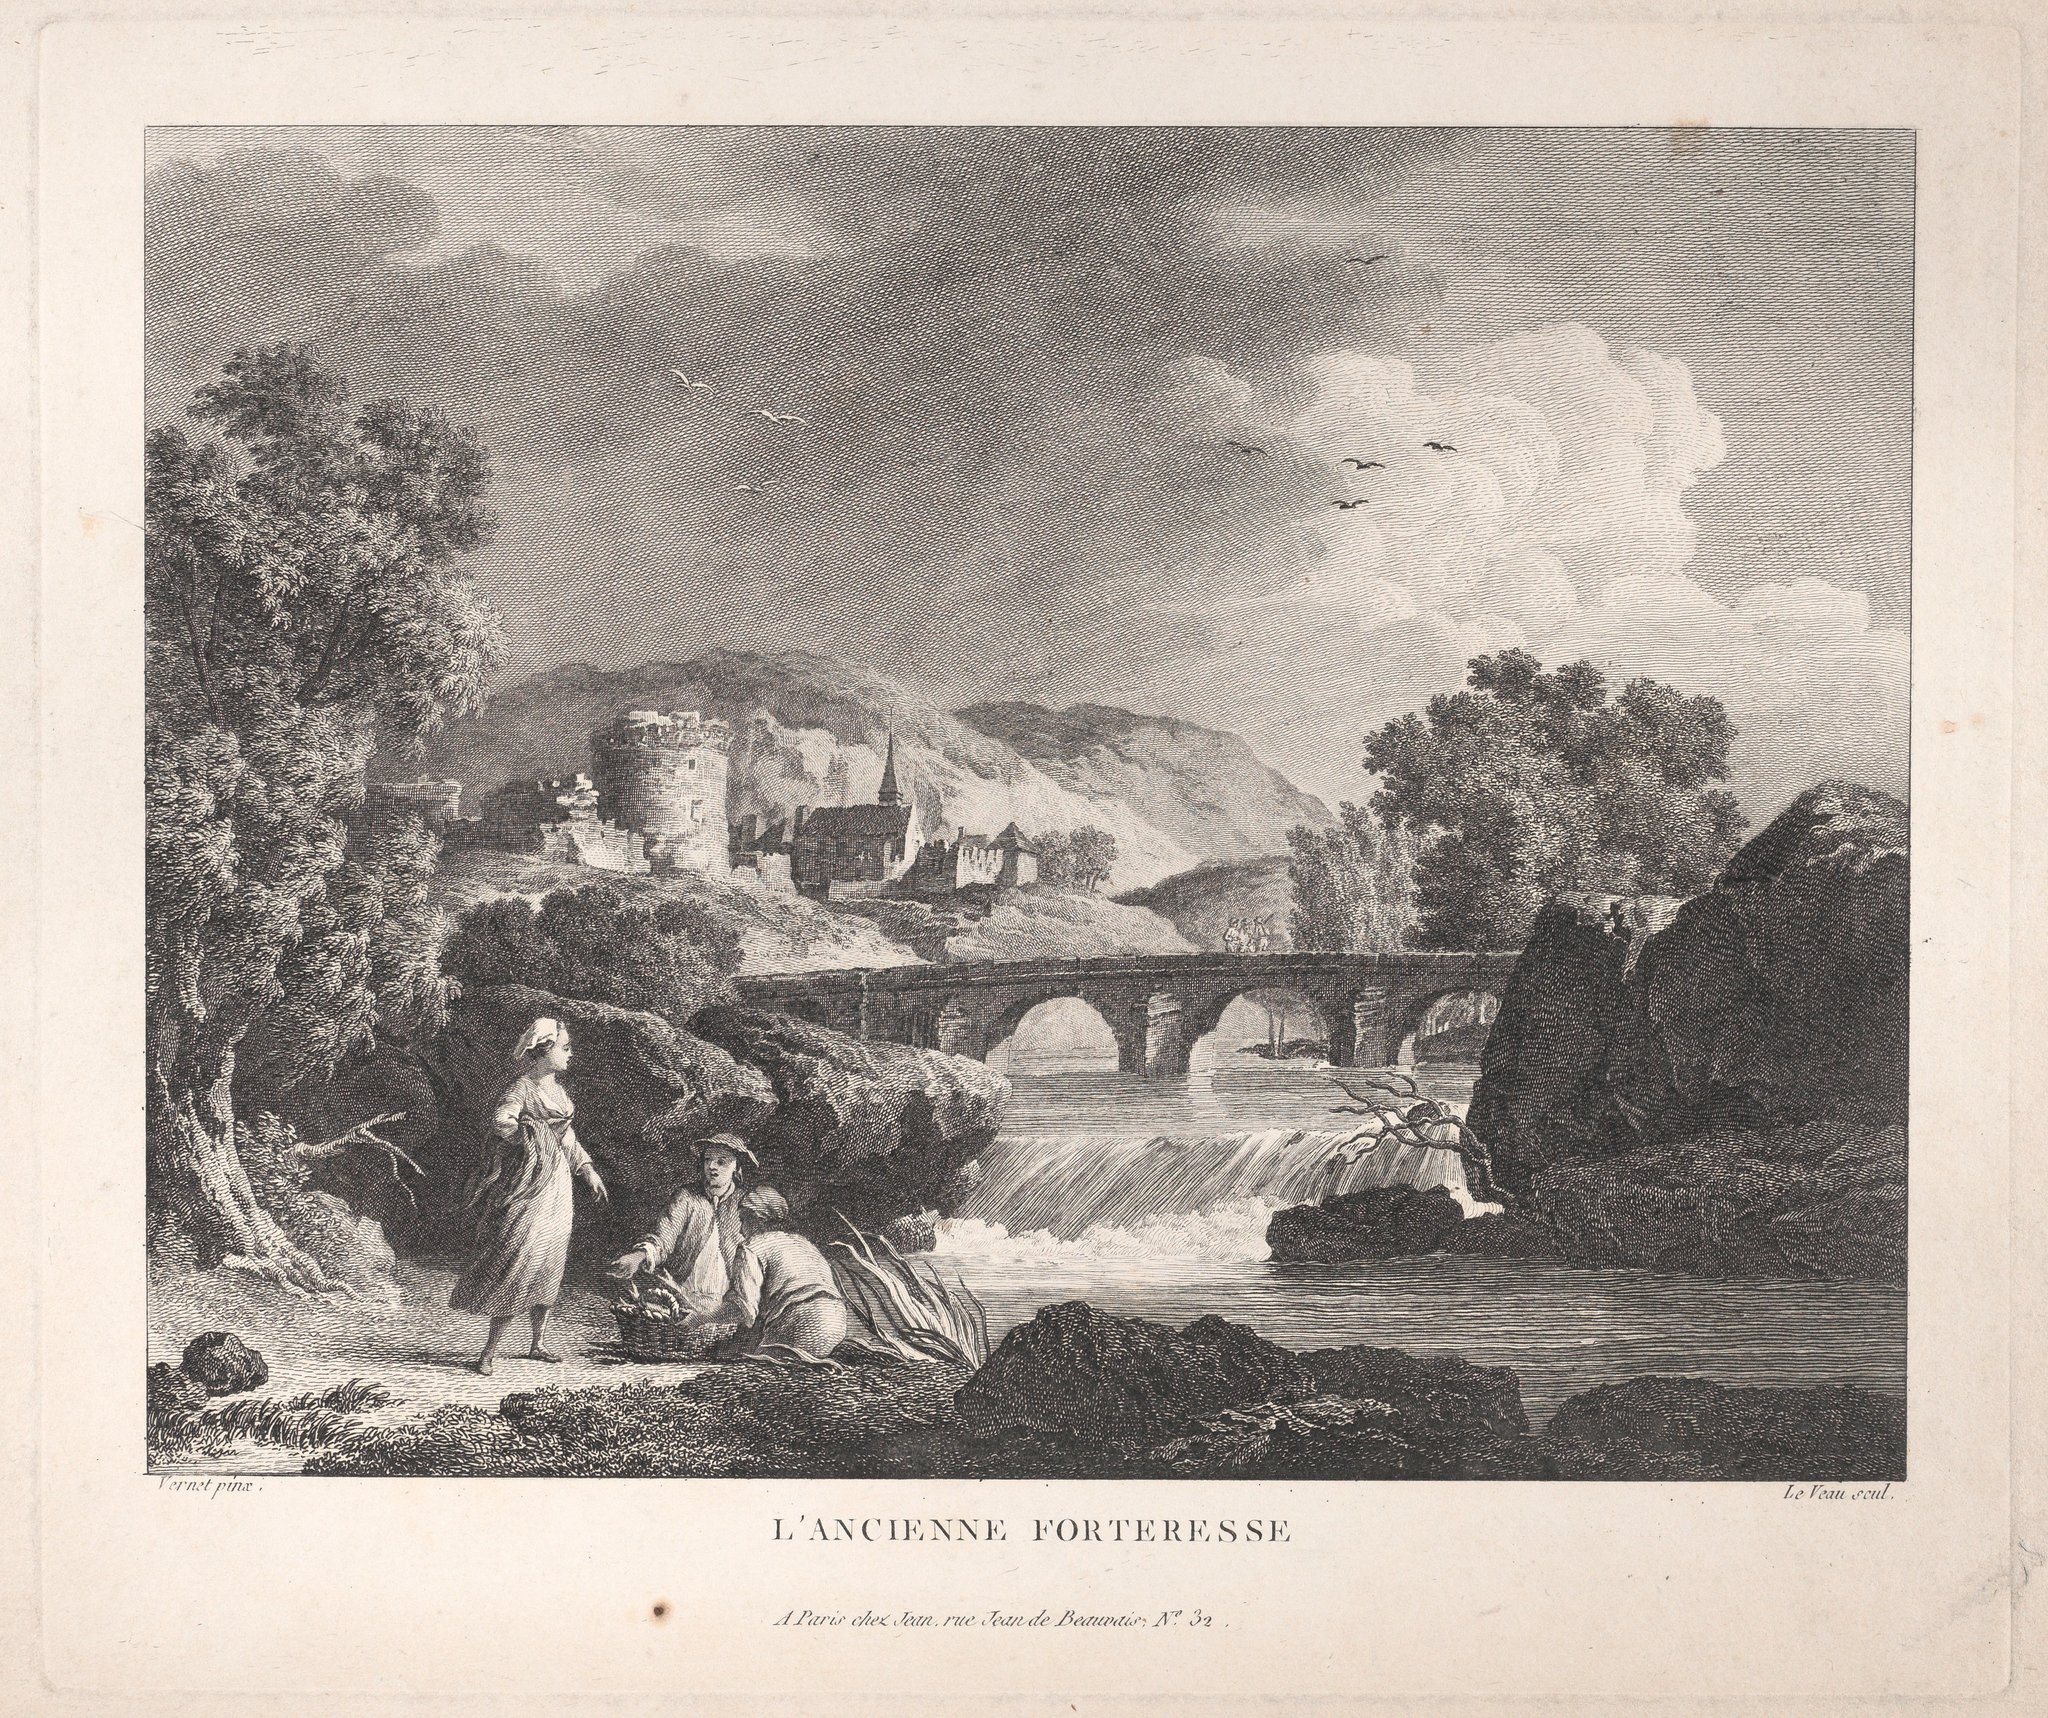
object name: print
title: The Old Fortress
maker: joseph vernet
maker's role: artist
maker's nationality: french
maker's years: 1714-1789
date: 1750-1800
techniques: engraving